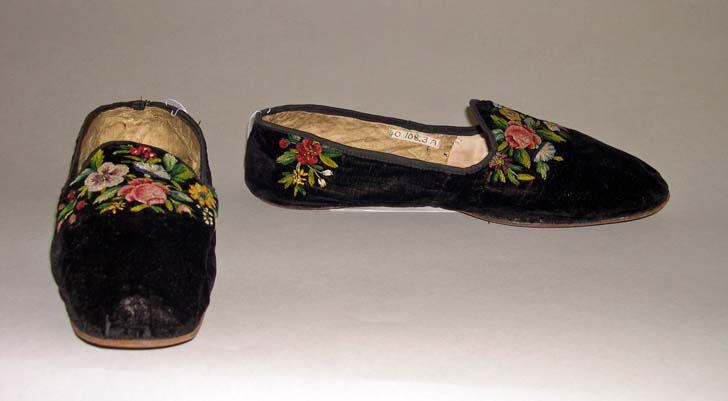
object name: slipper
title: Slippers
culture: american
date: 1834-1866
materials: silk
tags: flowers